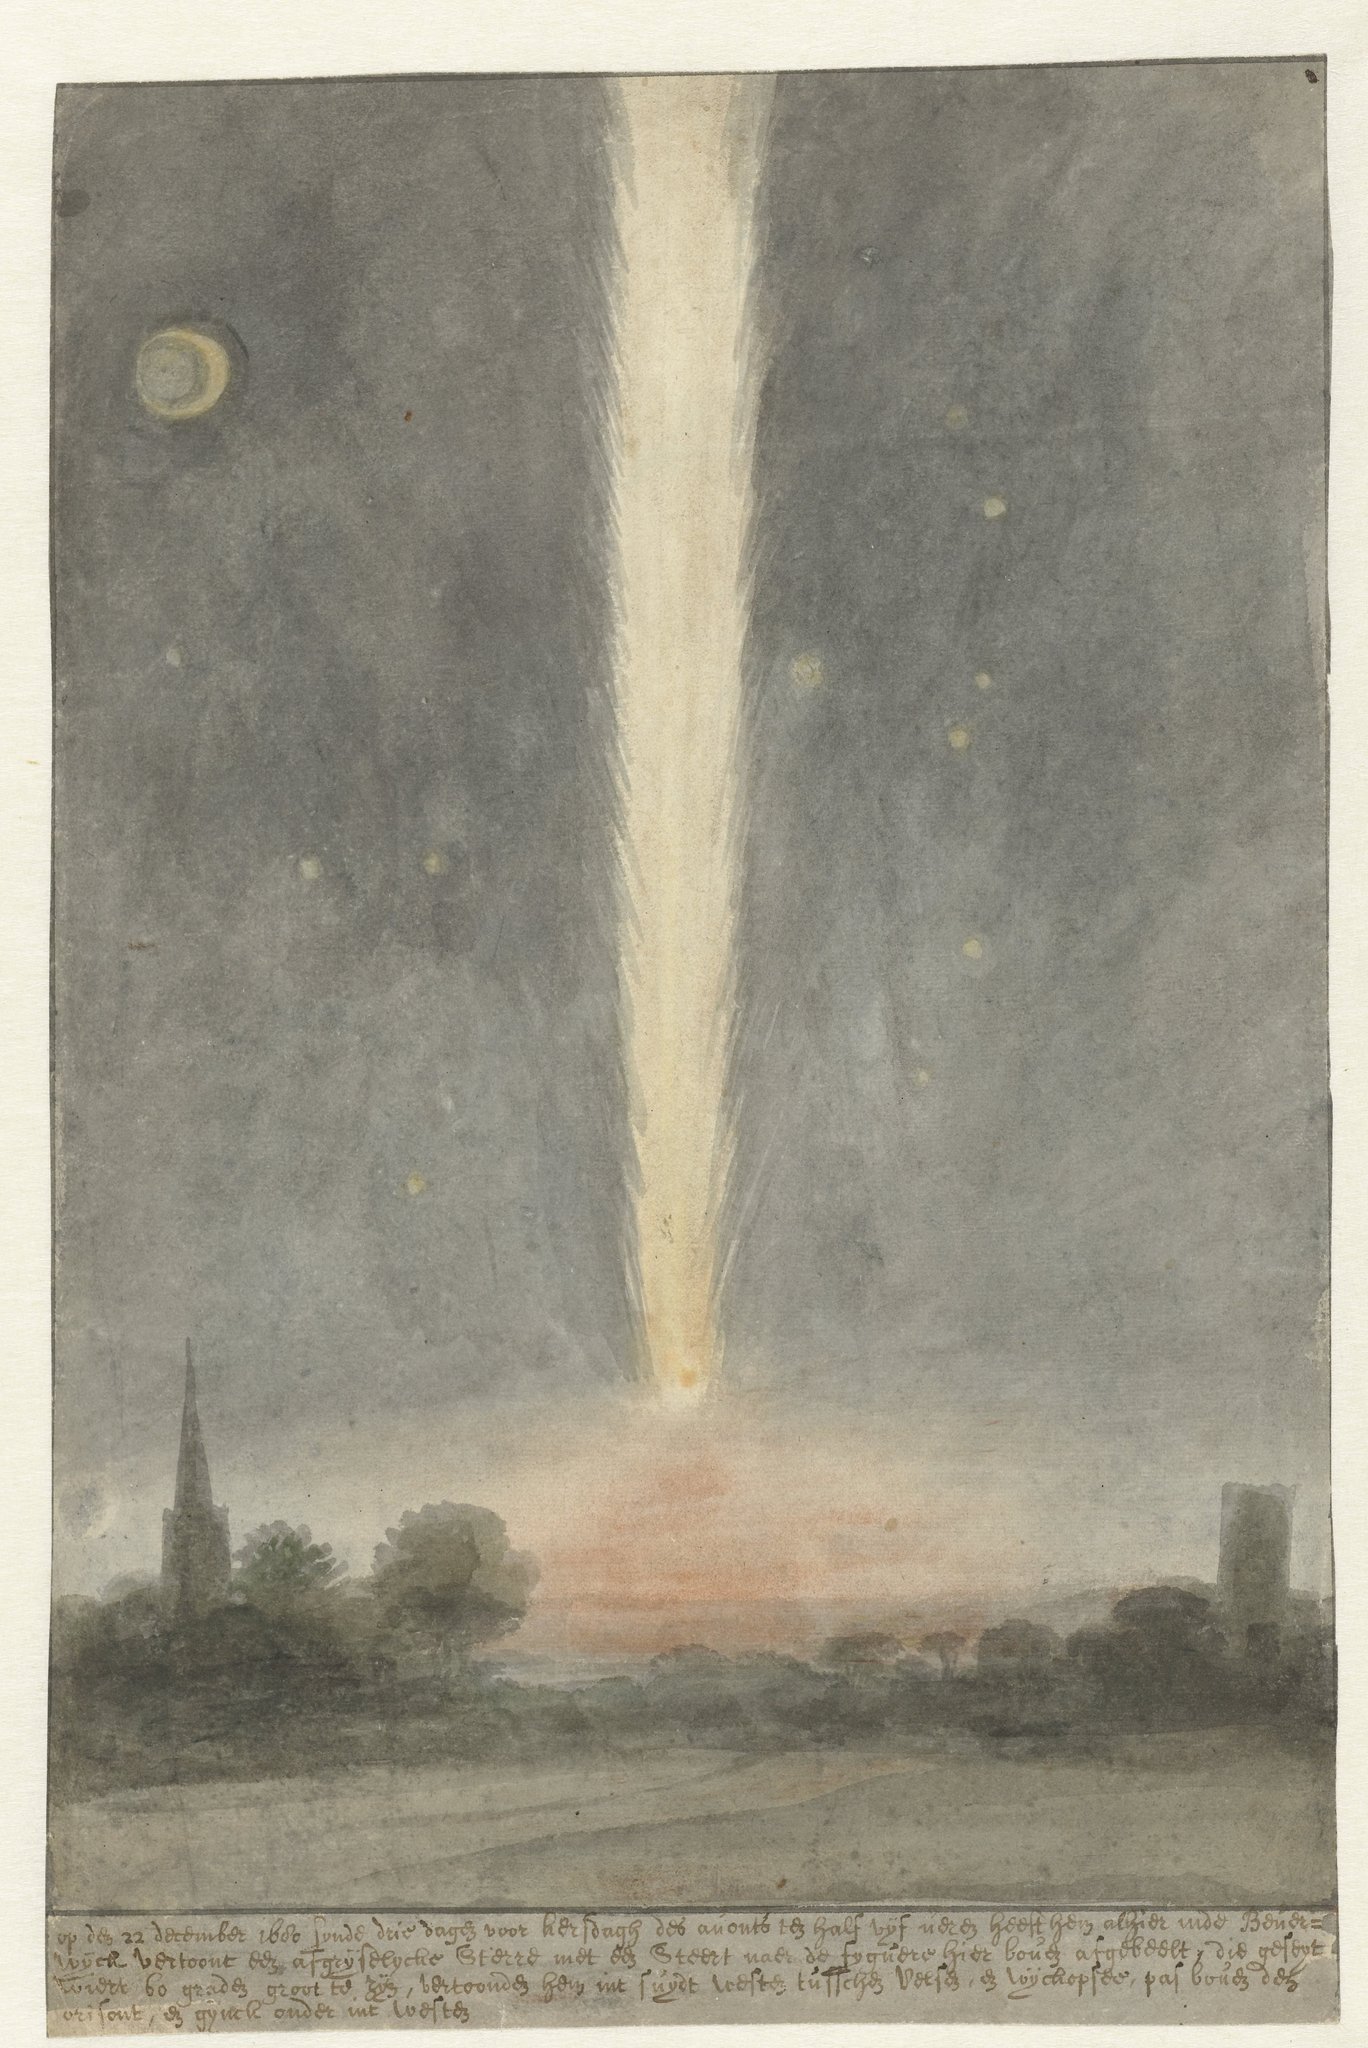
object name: watercolor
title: Staartster boven Beverwijk, 1680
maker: rochus van veen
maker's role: draughtsman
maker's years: 1640-1693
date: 1680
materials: chalk, paper, watercolor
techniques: brush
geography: beverwijk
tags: comet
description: De komeet of staartster zoals die zich op 22 december 1680 boven Beverwijk vertoonde. Landschap bij nacht met de komeet prominent aan de nachtelijk hemel tussen de maan en verschillende sterren. Met onderschrift van 4 regels in het Nederlands. Op de achterkant penseelstreken van gebladerte.